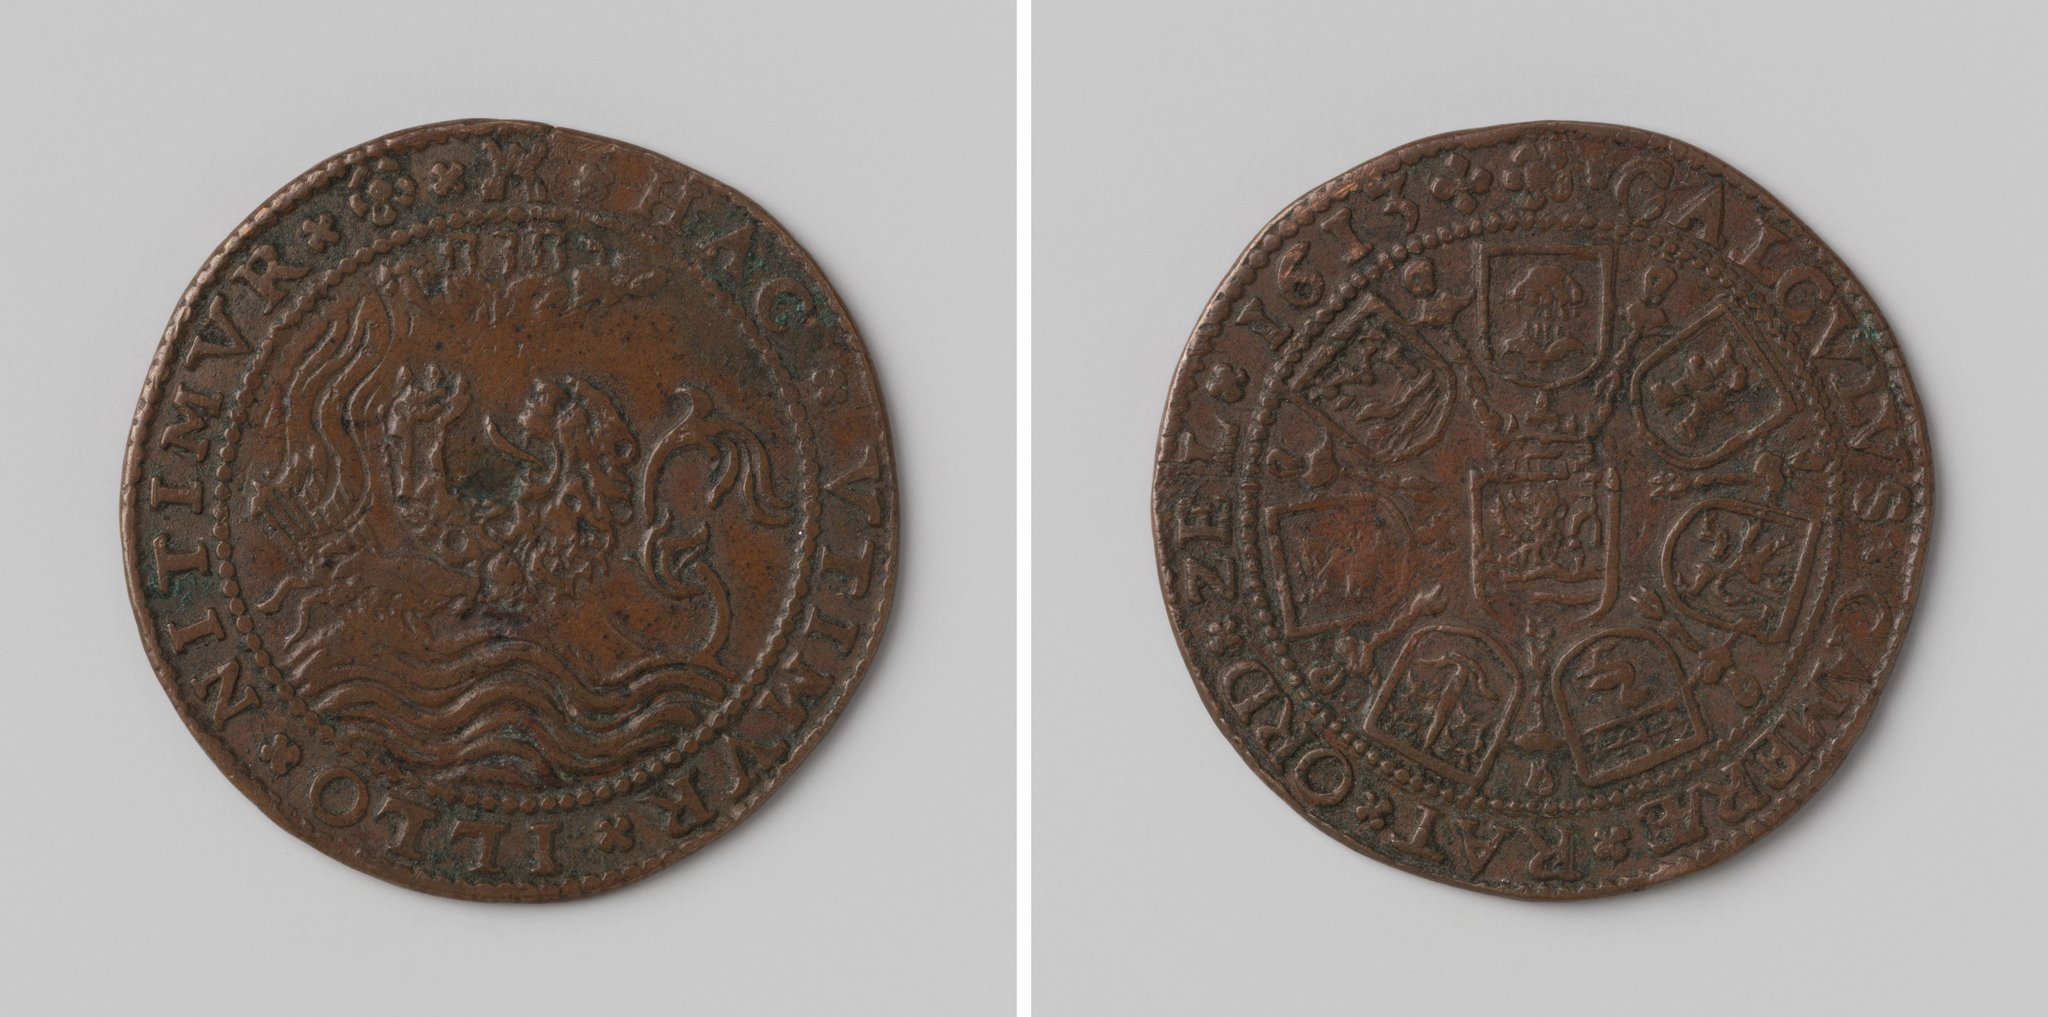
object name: jeton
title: Oproer te Utrecht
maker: Anonymous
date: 1613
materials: copper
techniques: striking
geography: middelburg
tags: zeeland, utrecht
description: Koperen penning. Voorzijde: leeuw met bundel van zeven pijlen in klauw, tot zijn middel staande in water beschenen door hemellicht, met daarin naam Jehovah in Hebreeuws schrift binnen omschrift. Keerzijde: gekroond wapenschild, omgeven door rand van zeven met lint samengebonden wapenschilden binnen omschrift